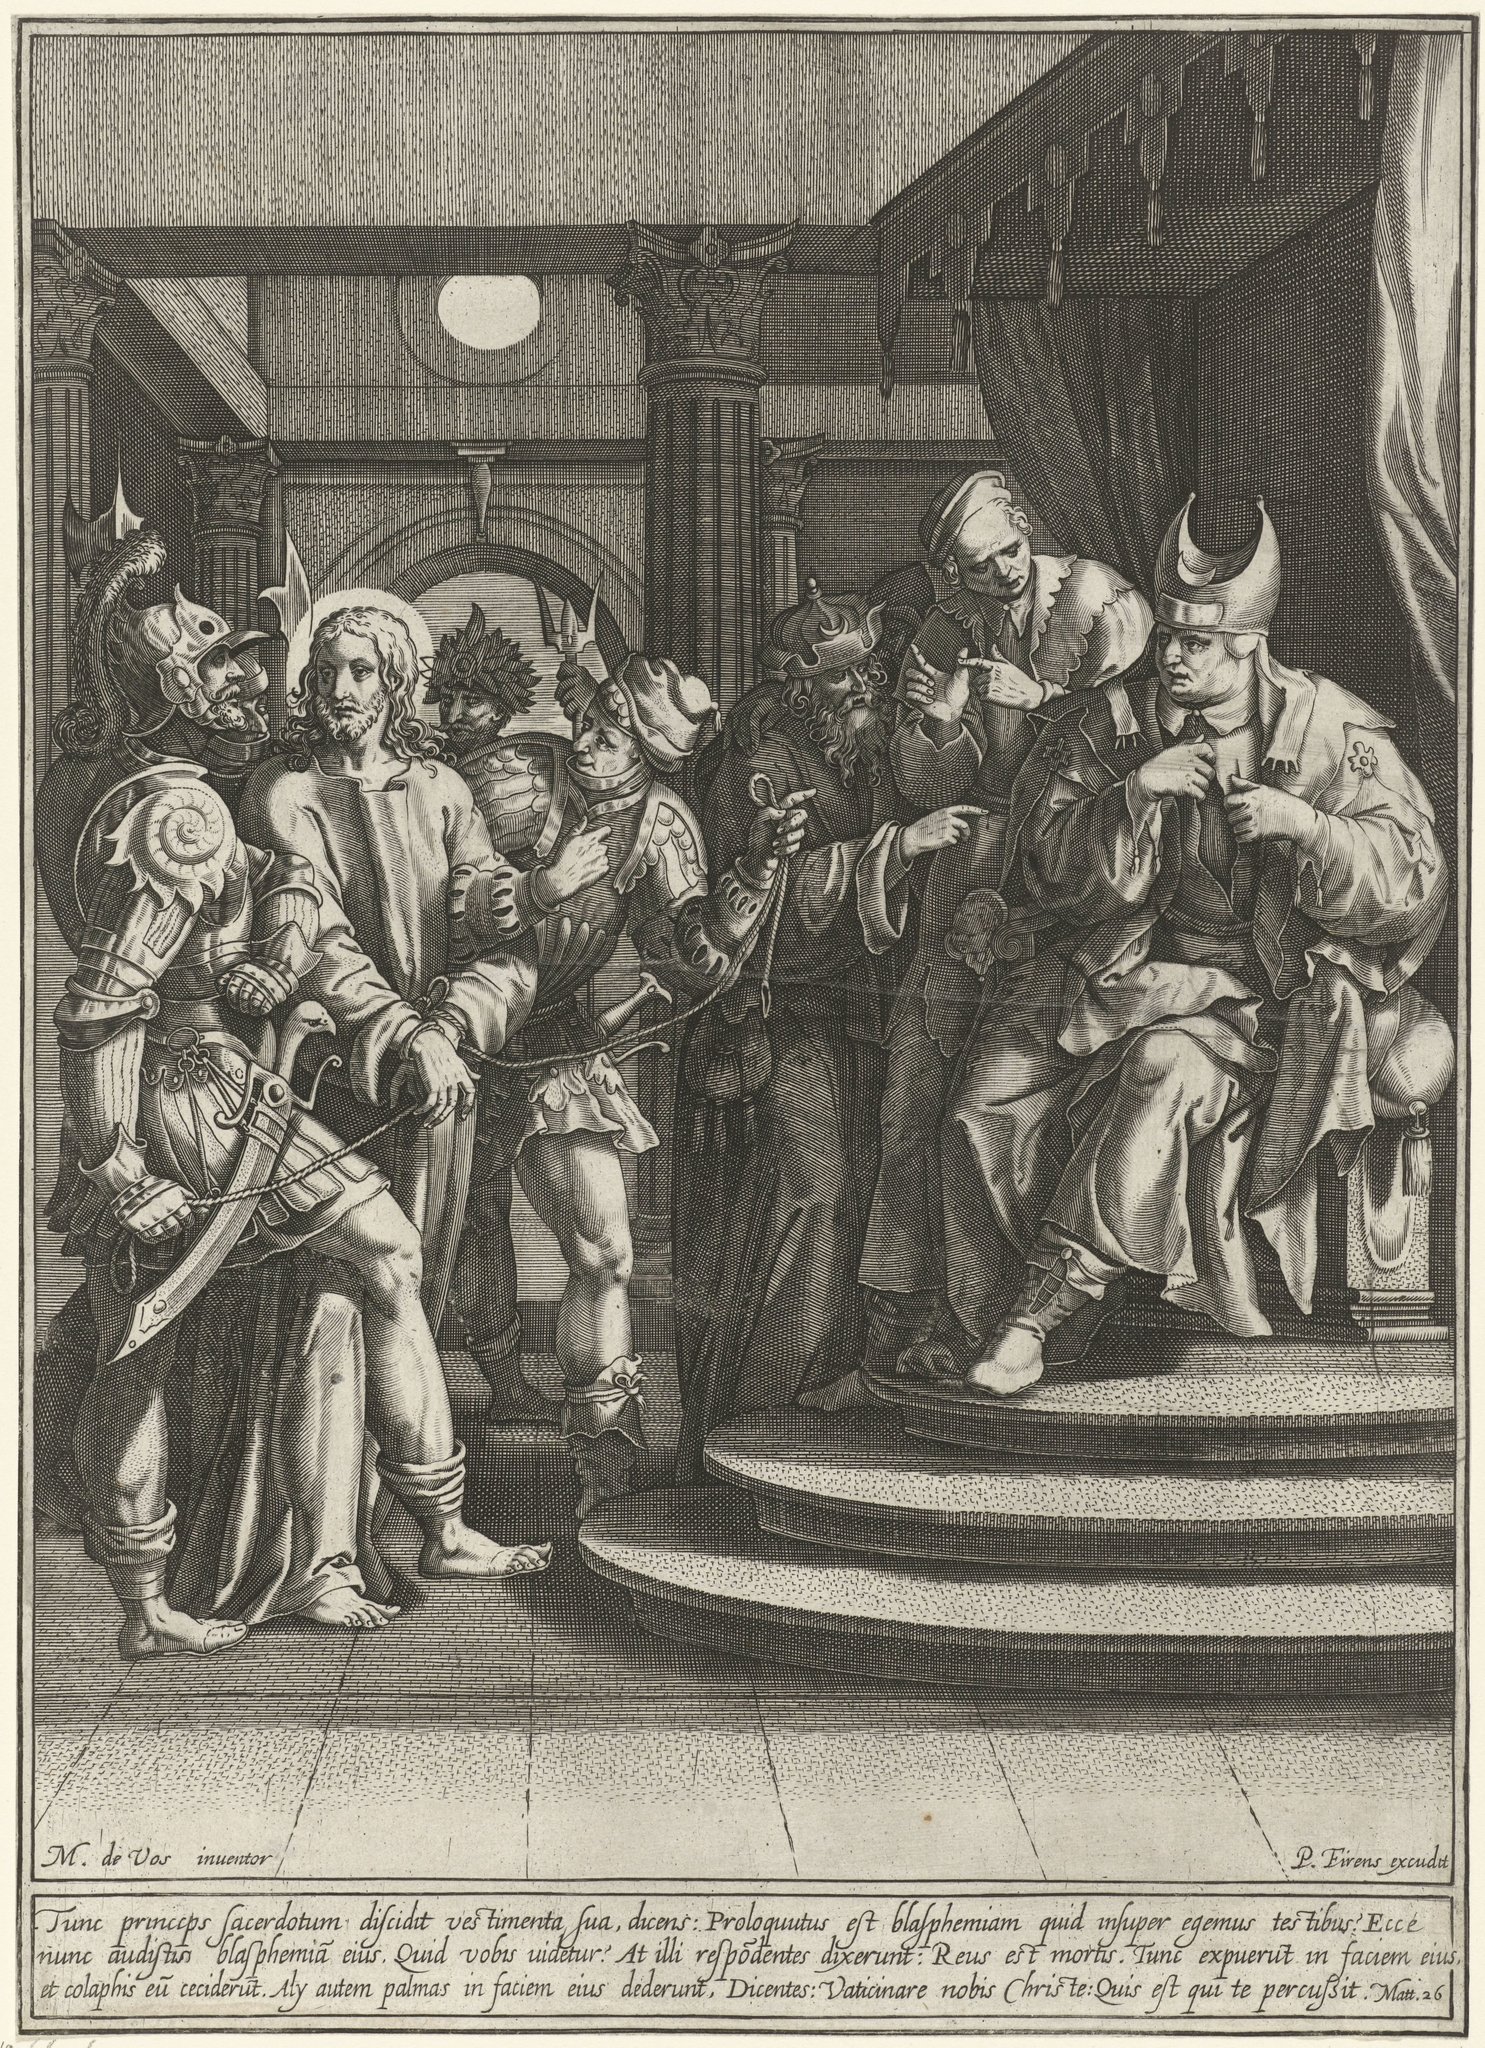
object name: print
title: Passie en wederopstanding van Christus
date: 1590-1638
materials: paper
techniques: engraving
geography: antwerp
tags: christ before the sanhedrin with caiaphas as high priest, and possibly annas; maybe a soldier about to strike christ because he keeps silent (matthew 26:57-66; mark 14:53-64; luke 22:54, 22:66-71)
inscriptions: collector's mark: Lugt 2760, collector's mark: Lugt 2228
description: Christus wordt voor de troon van hogepriester Kajafas (rechts) geleid. De prent heeft een Latijns onderschrift met een tekst uit de Bijbel en is de vierde prent van een veertiendelige serie over de passie van Christus.